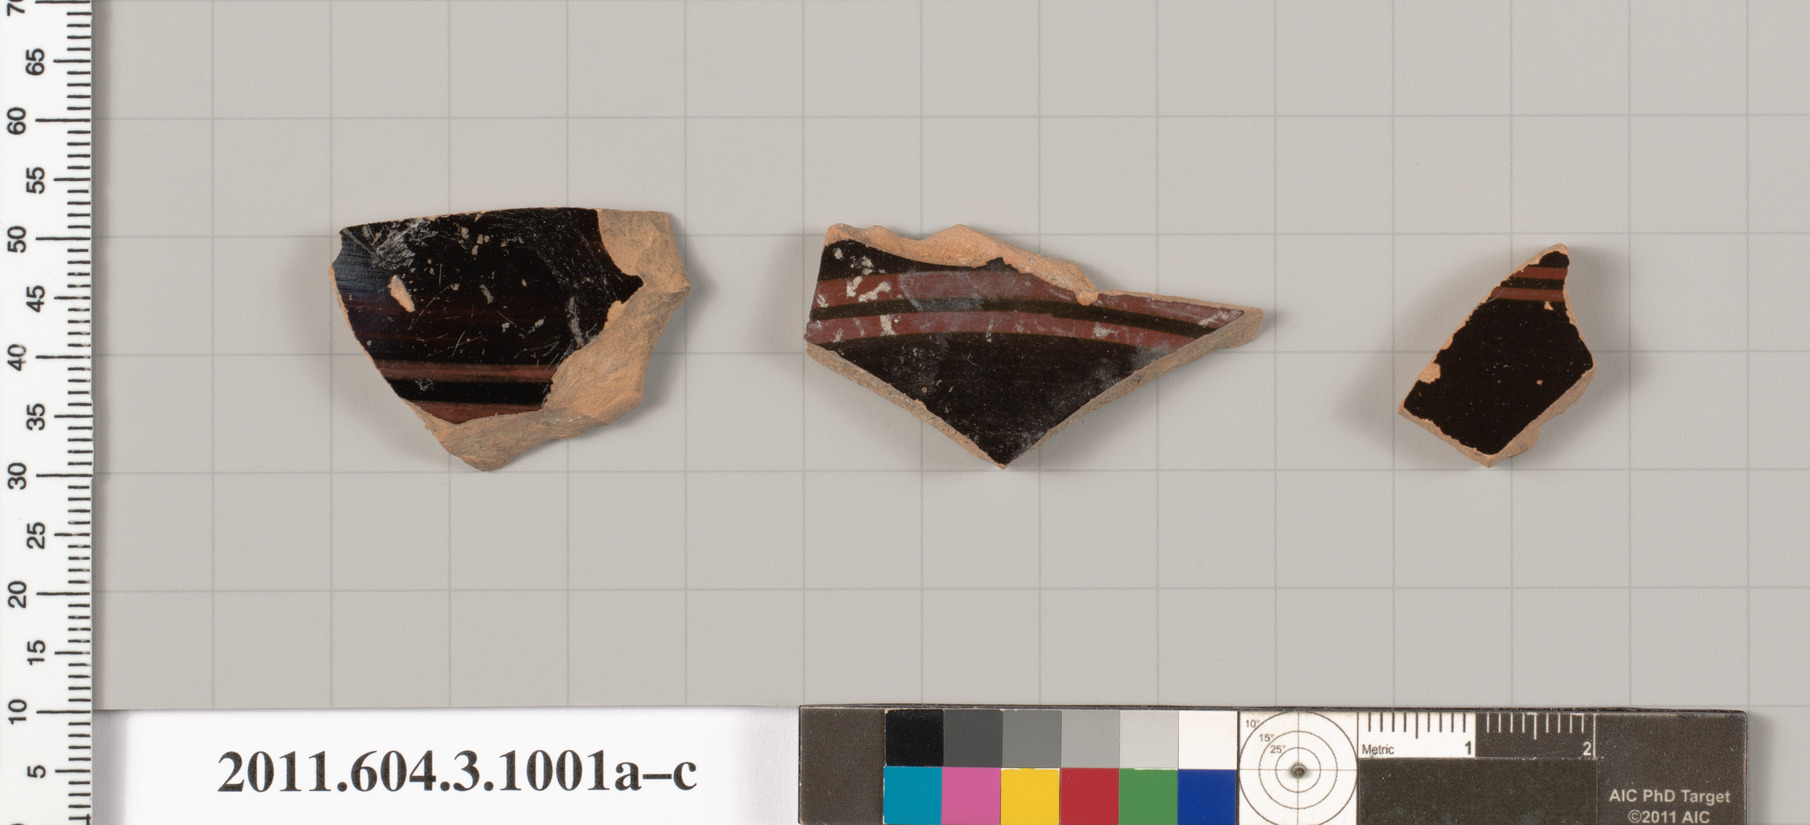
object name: lekanis fragment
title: Terracotta fragments of lekanides (covered dishes)?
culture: greek, attic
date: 600-501 BCE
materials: terracotta